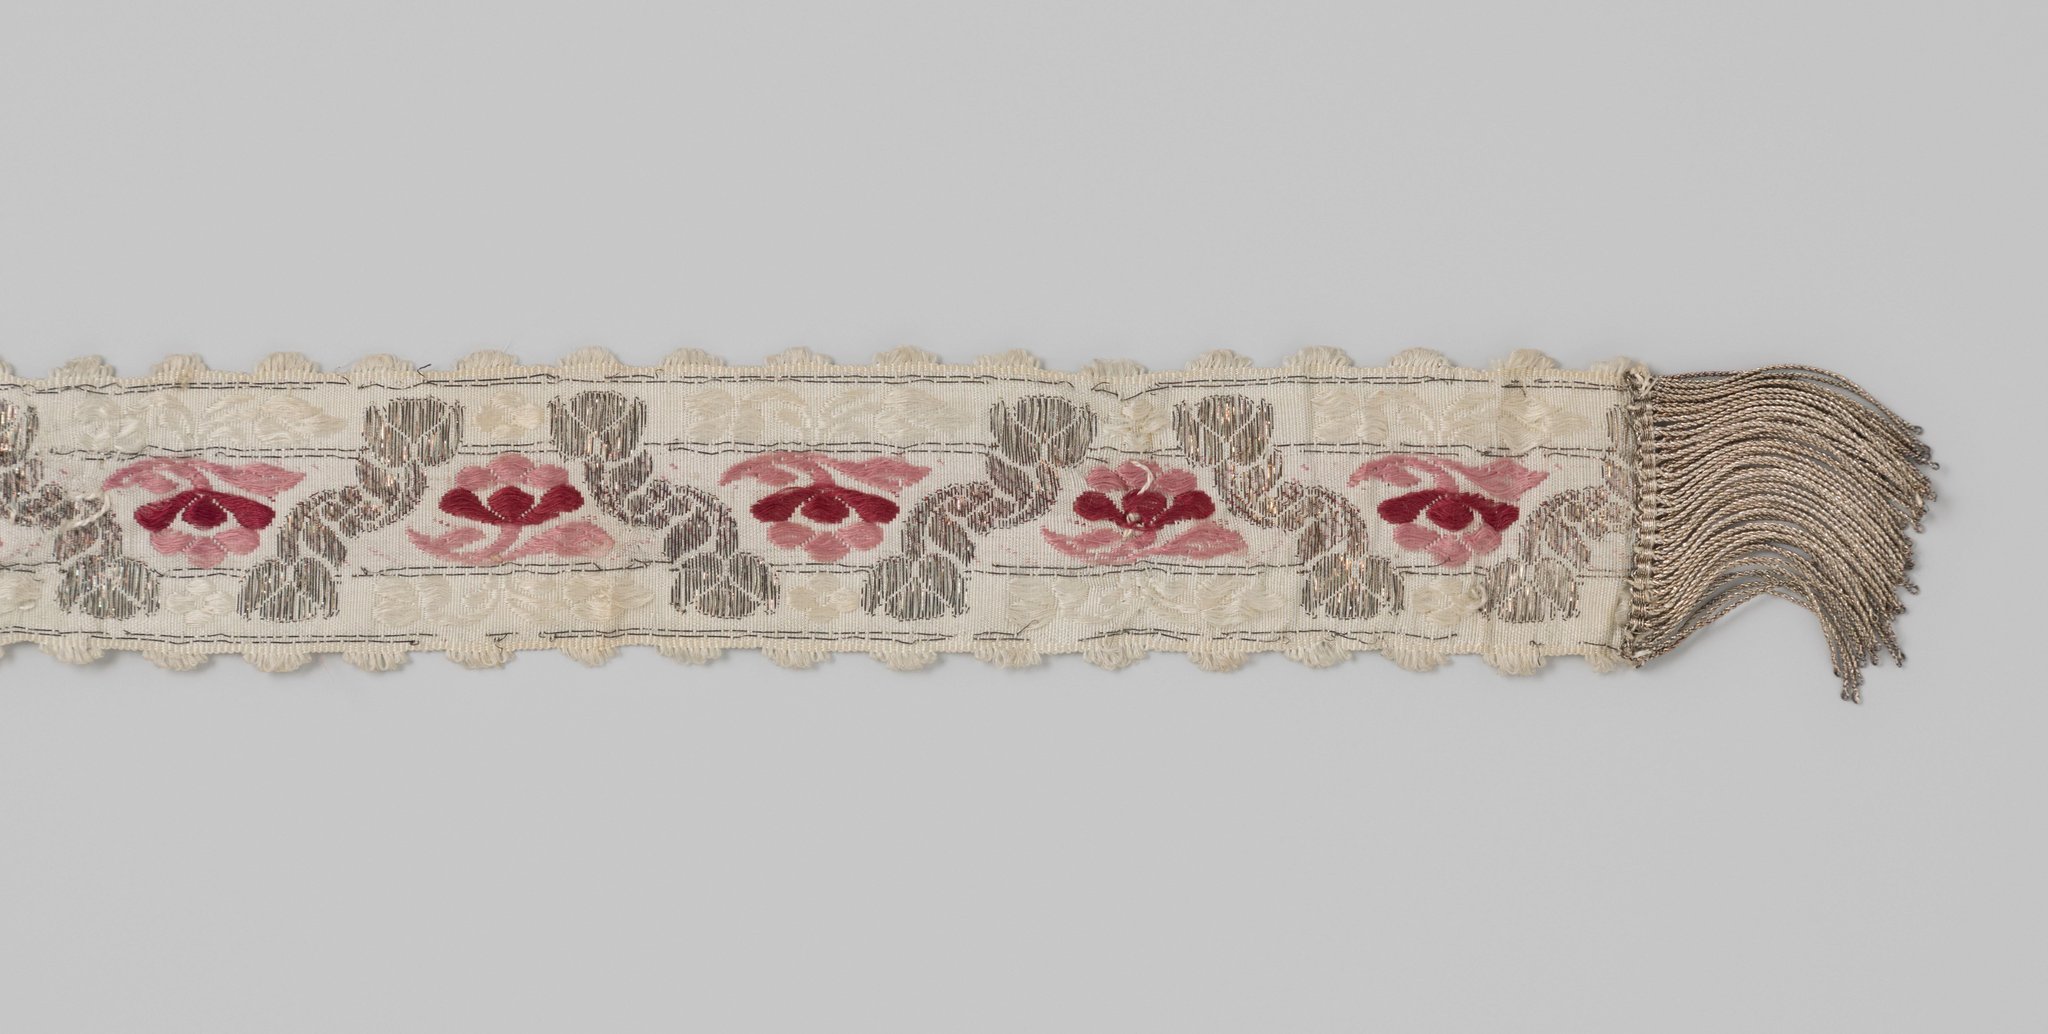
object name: clothing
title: Lint van zijdebrokaat; op een witte ondergrond is een zilverkleurig zigzagpatroon aangebracht waartussen rode en roze bloemen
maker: Anonymous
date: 1790-1810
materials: silk, thread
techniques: brocade, weave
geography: western europe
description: Lint van zijdebrokaat; op een witte ondergrond is een zilverkleurig zigzagpatroon aangebracht waartussen rode en roze bloemen. De randen zijn afgezet met een sierband. Aan de uiteinden franje van zilverdraad.